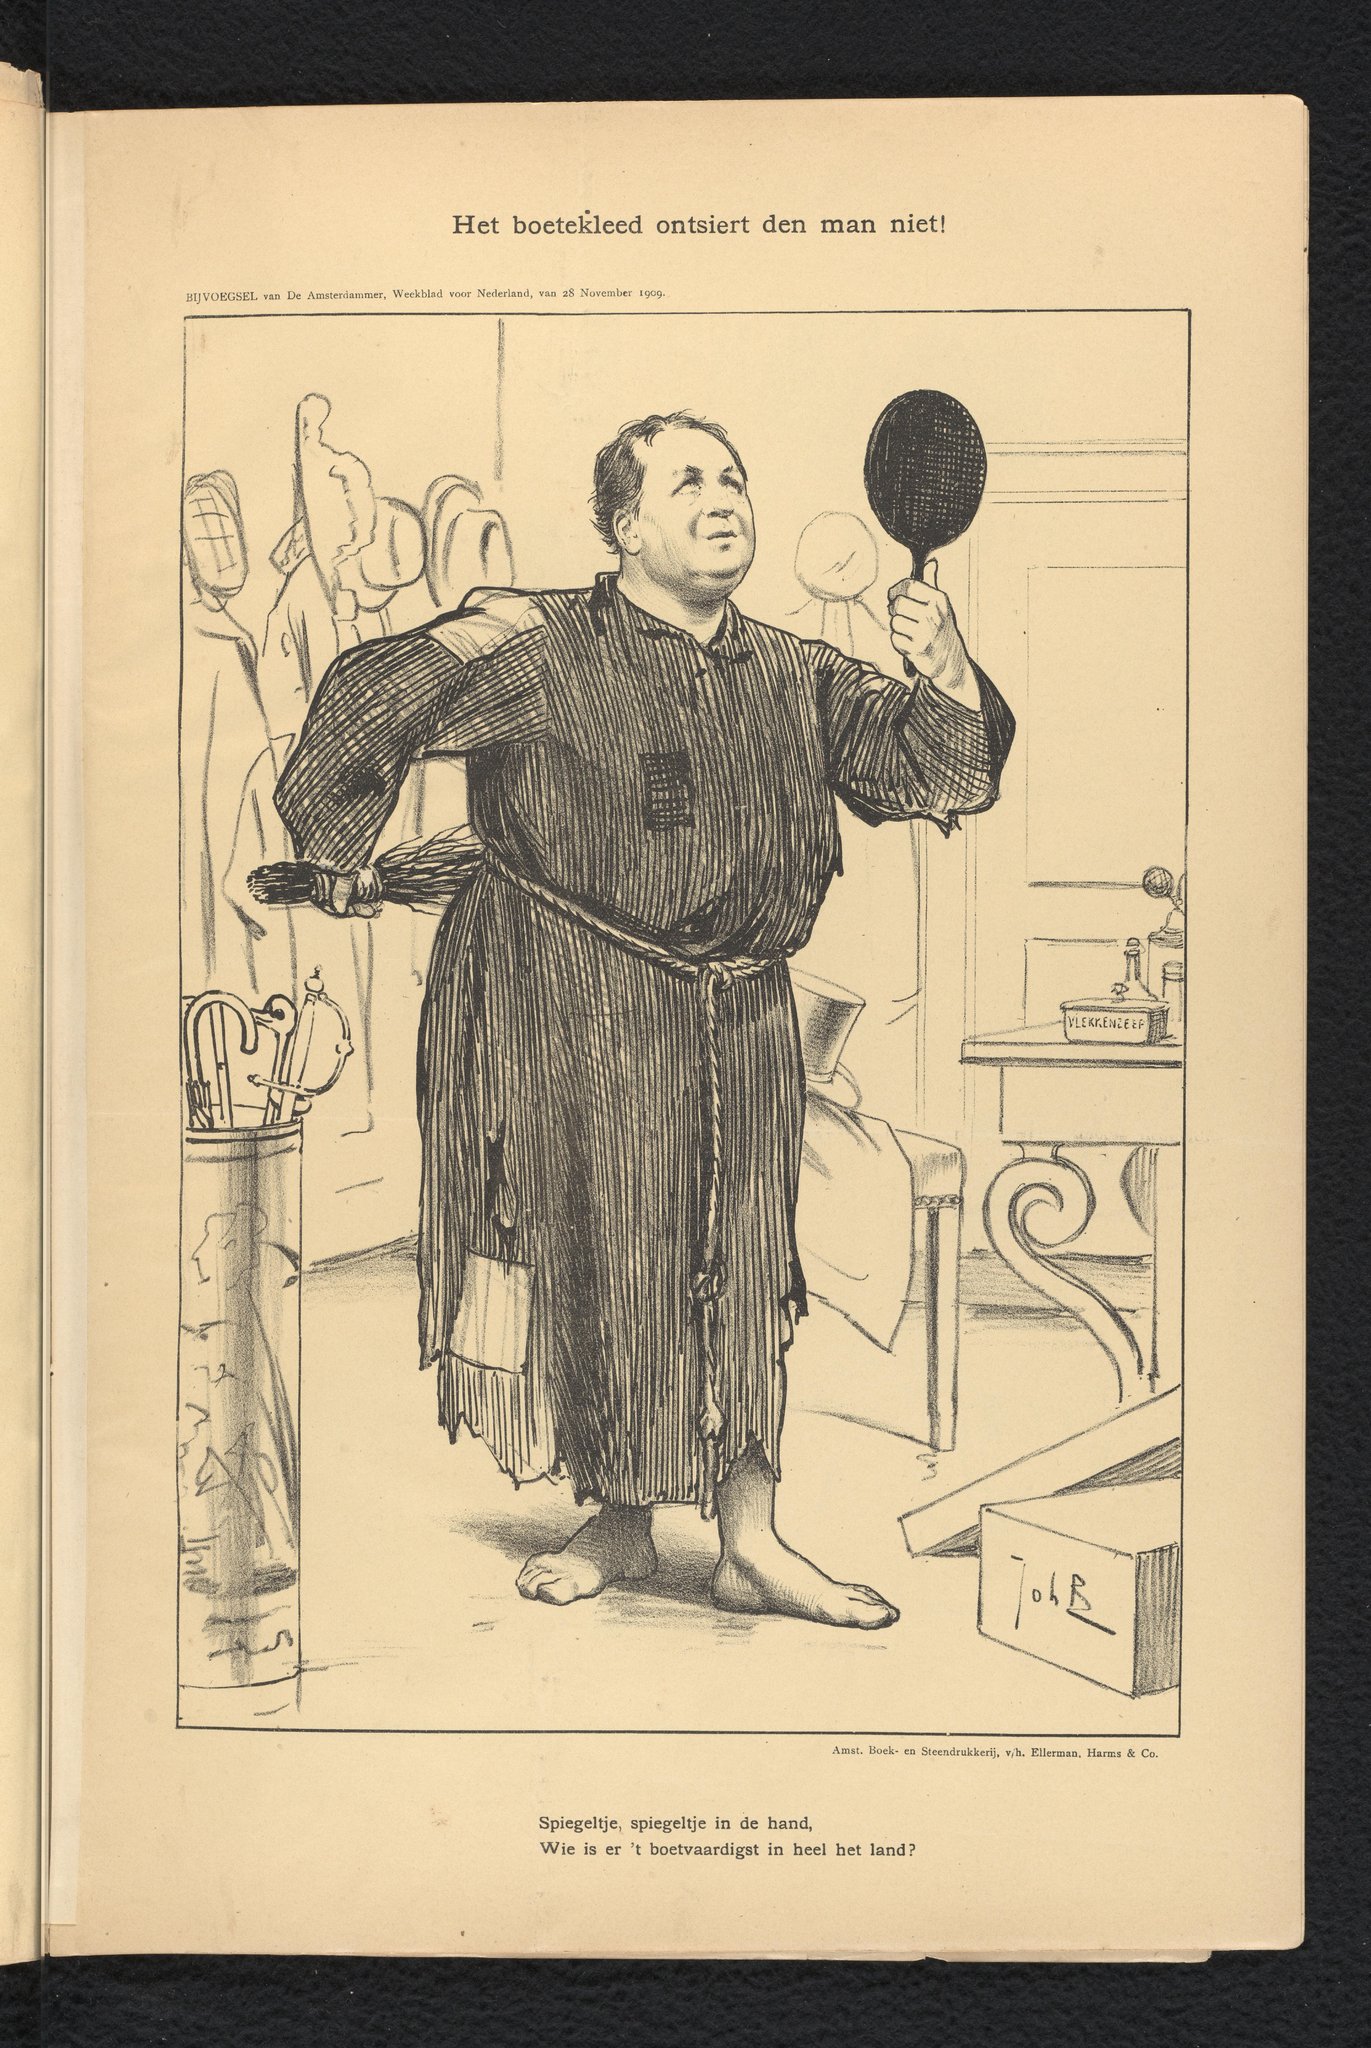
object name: cartoon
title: Het boetekleed ontsiert den man niet!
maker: johan braakensiek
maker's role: draughtsman, print maker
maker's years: 1858-1940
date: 1909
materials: paper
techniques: lithograph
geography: netherlands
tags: the hague, abraham kuyper, penitence, repentance; 'penitenza', 'pentimento', 'pentimento de'peccati', 'purgatione de peccati' (ripa), looking in the mirror; contemplation of own beauty, self-castigation ~ ascetic life, political caricatures and satires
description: Abraham Kuyper in boetekleed bewondert zijn spiegelbeeld. Met een roe geselt hij licht zijn achterste.